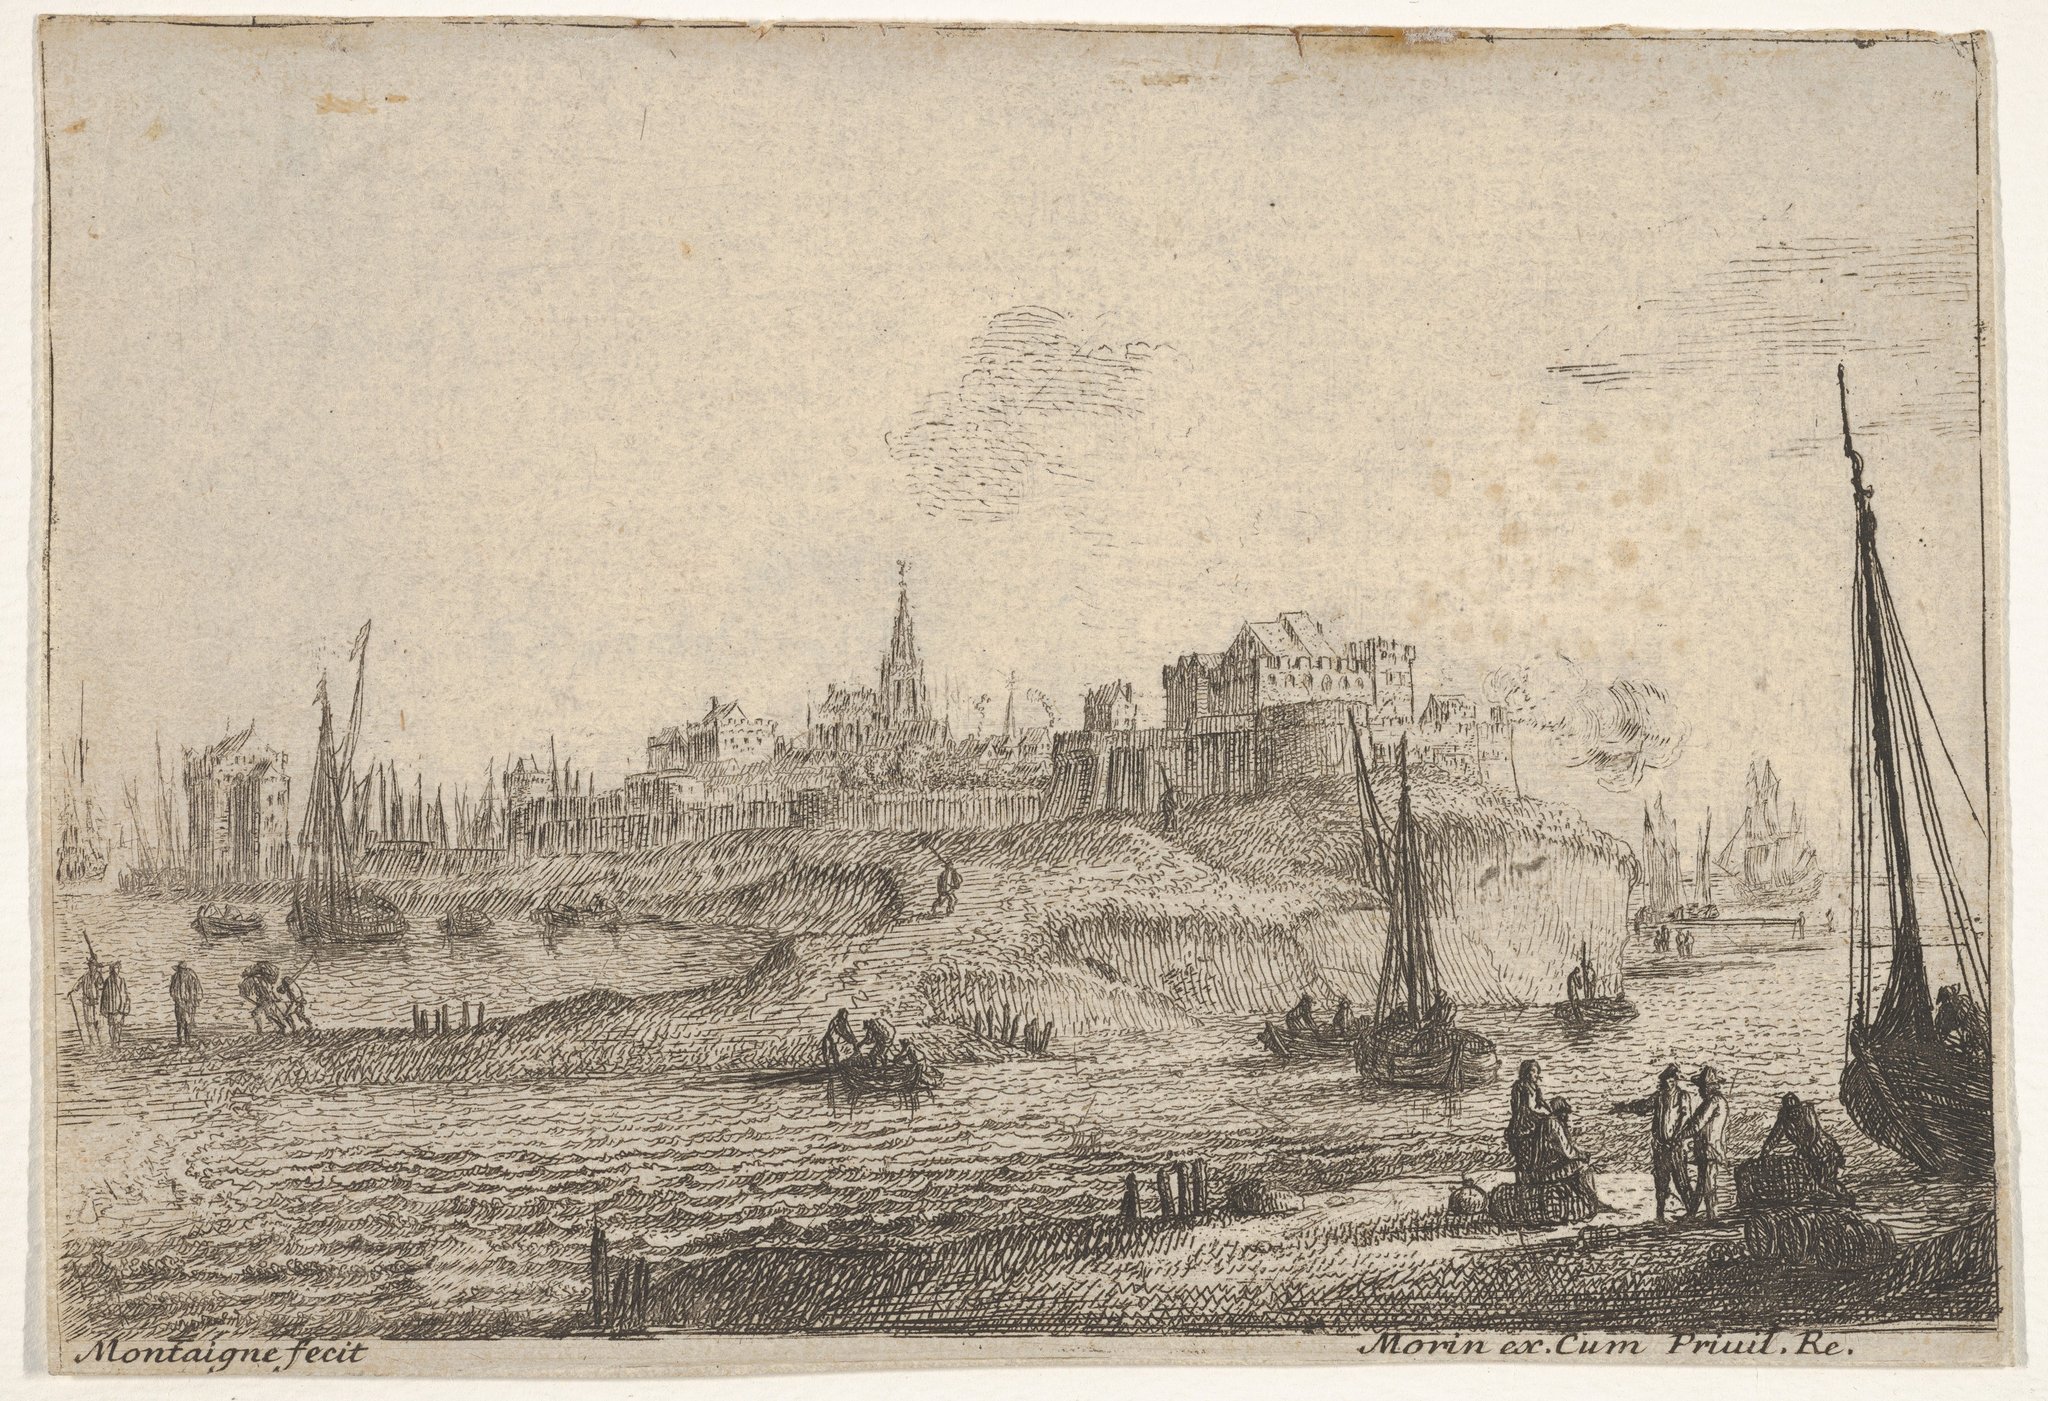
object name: print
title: View of a peninsula with figures and ships with bare masts, in the right foreground five figures congregate around two barrels, town buildings beyond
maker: matthijs van plattenberg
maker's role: artist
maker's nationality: flemish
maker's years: 1600-1660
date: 1625-1660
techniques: etching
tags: towns,boats